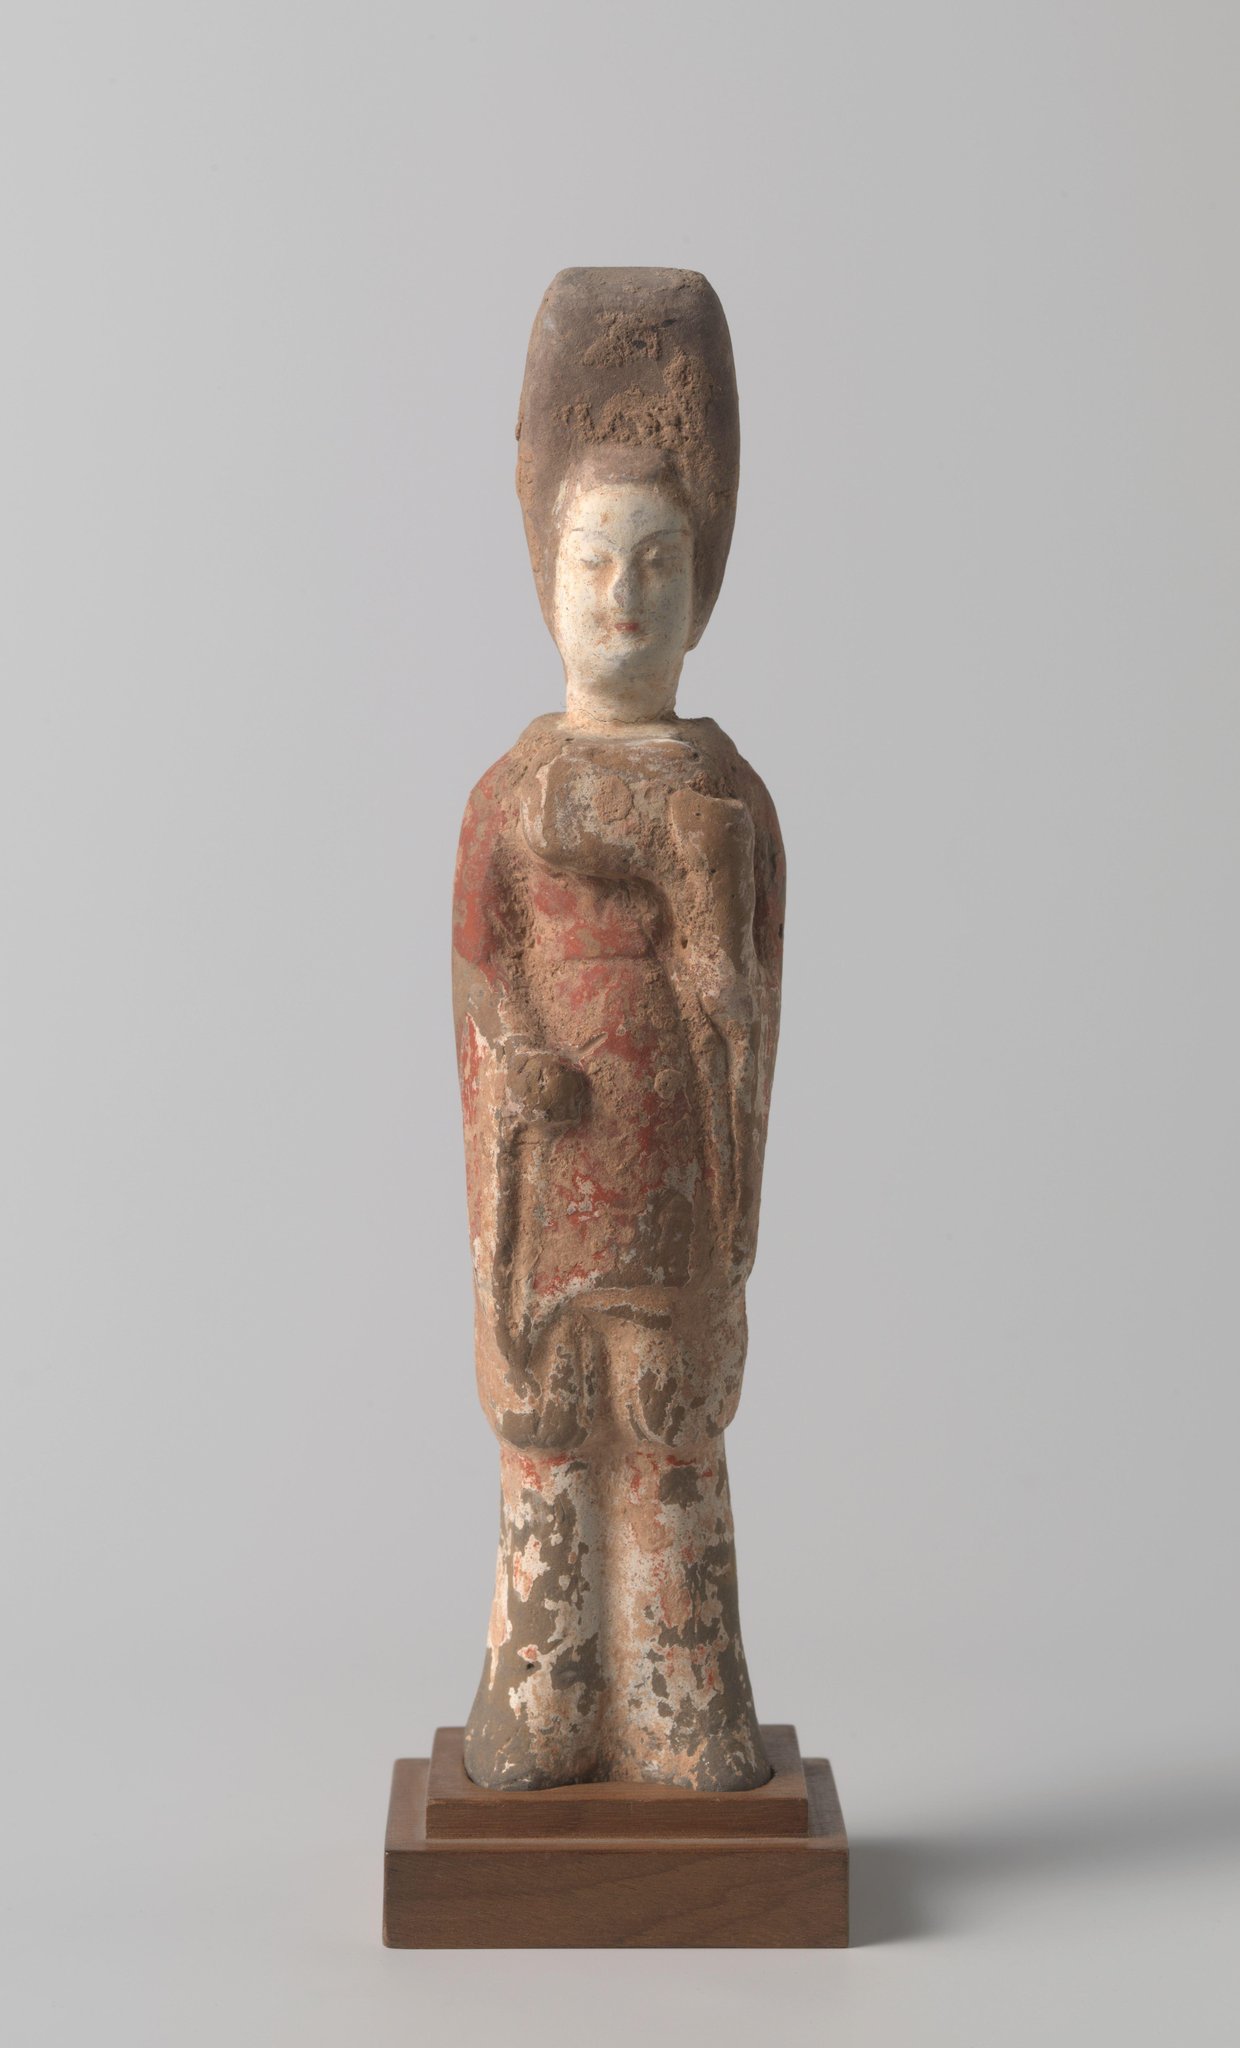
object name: tomb figure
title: Funeral figure in the shape of a woman with an instrument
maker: Anonymous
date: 220-589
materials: earthenware, paint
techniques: forming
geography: china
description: Staande graffiguur, musicienne, op een los houten voetstuk. De figuur is gekleed in een rood gewaad met V-hals en wijde mouwen en heeft een hoog opgewerkt kapsel. De beschildering is in rood, zwart en wit. Zij houdt een rechthoekig voorwerp in de hand.